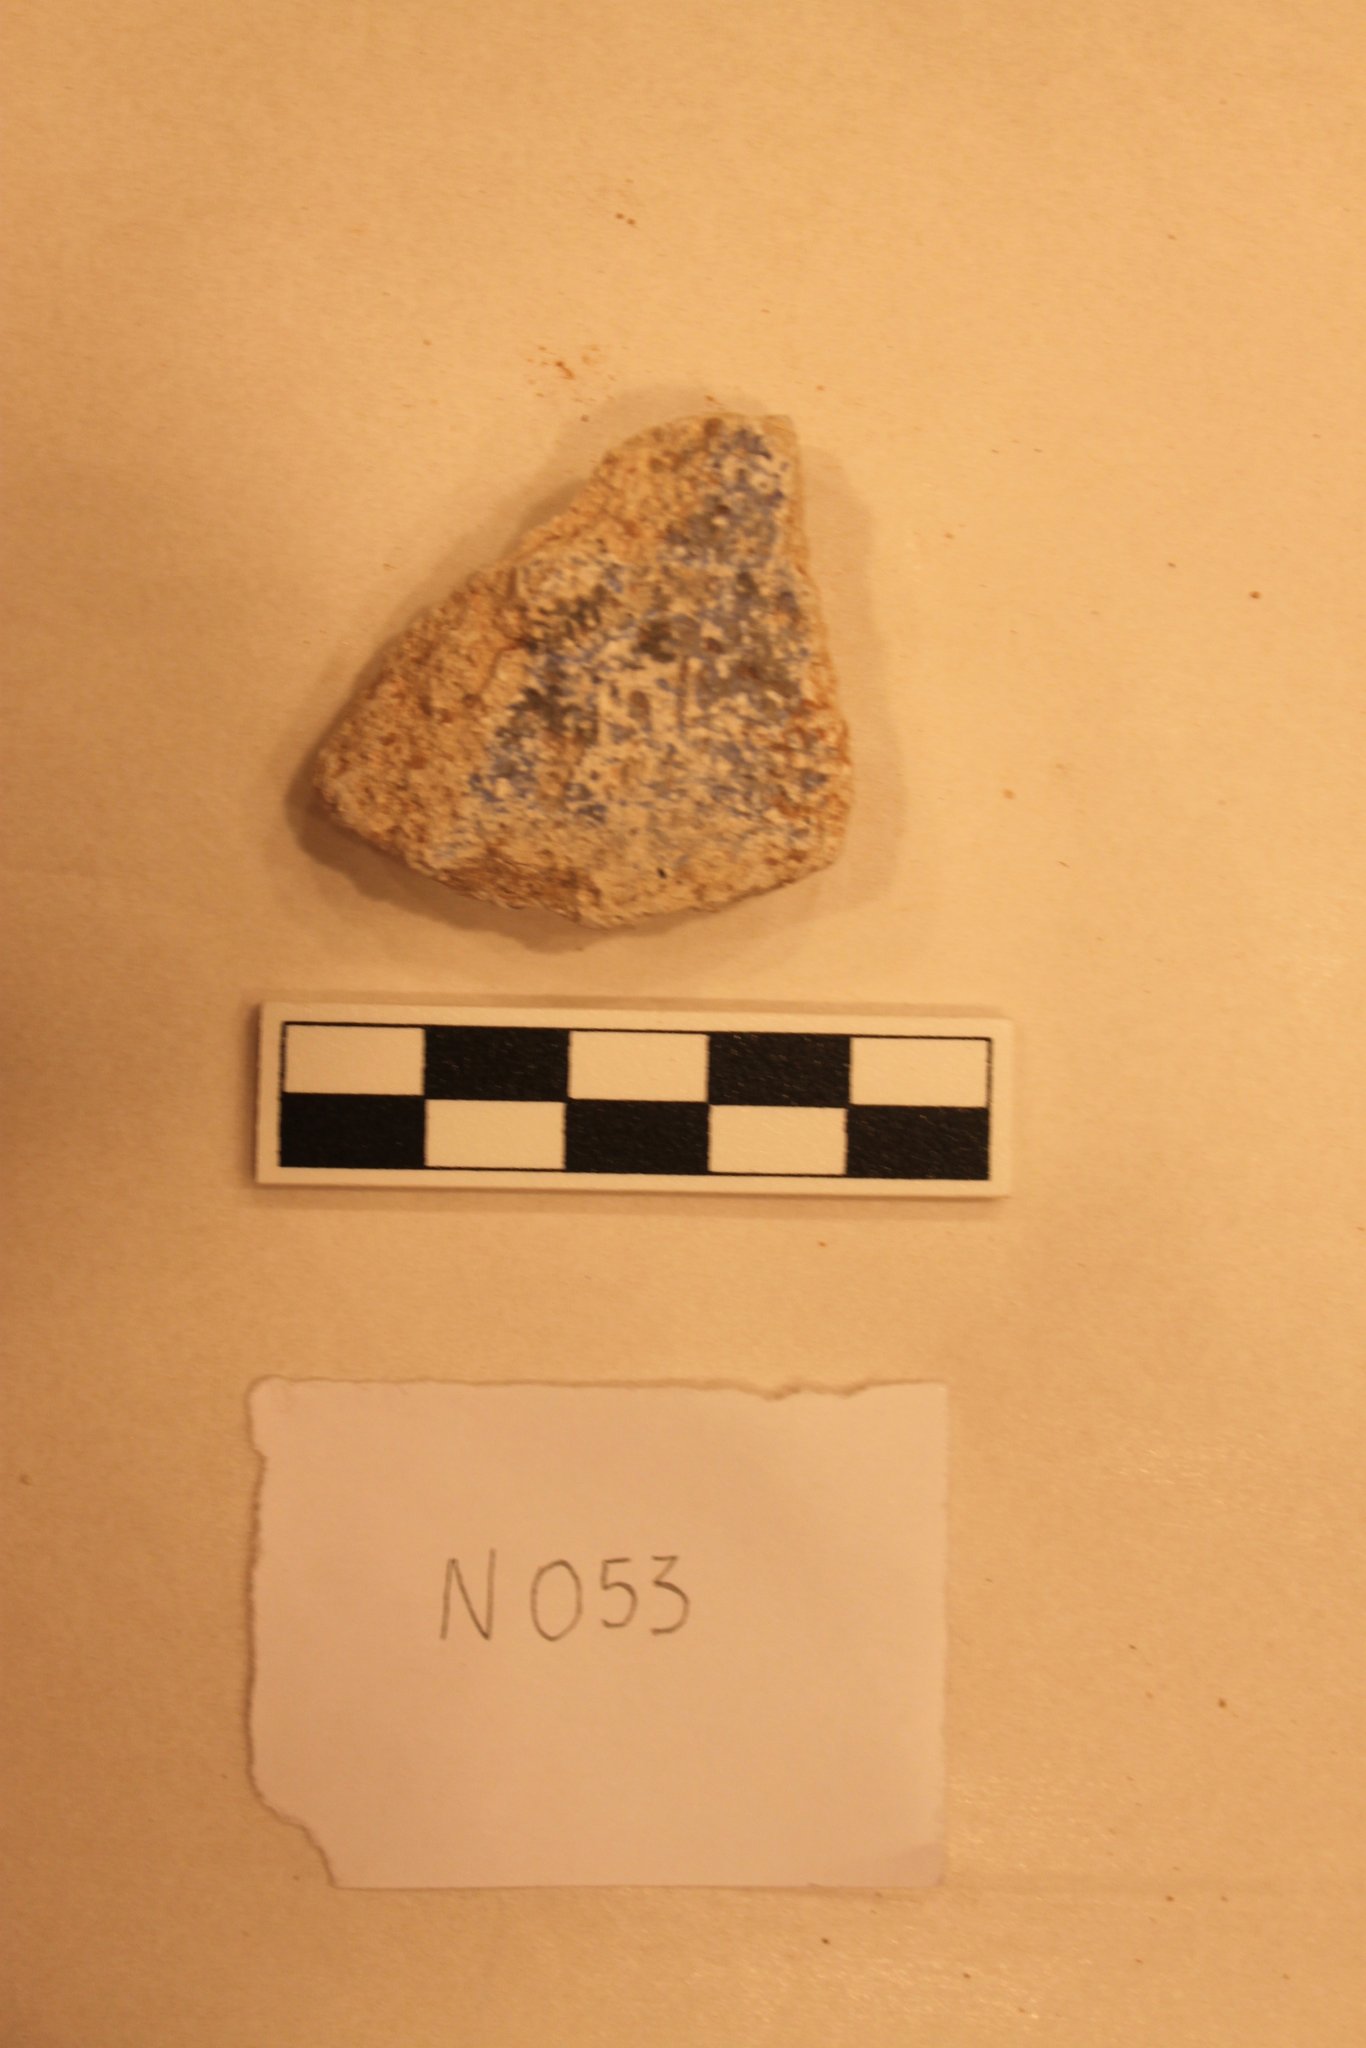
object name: fragment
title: Stucco Fragment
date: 701-1200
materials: plaster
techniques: carving, painting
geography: iran